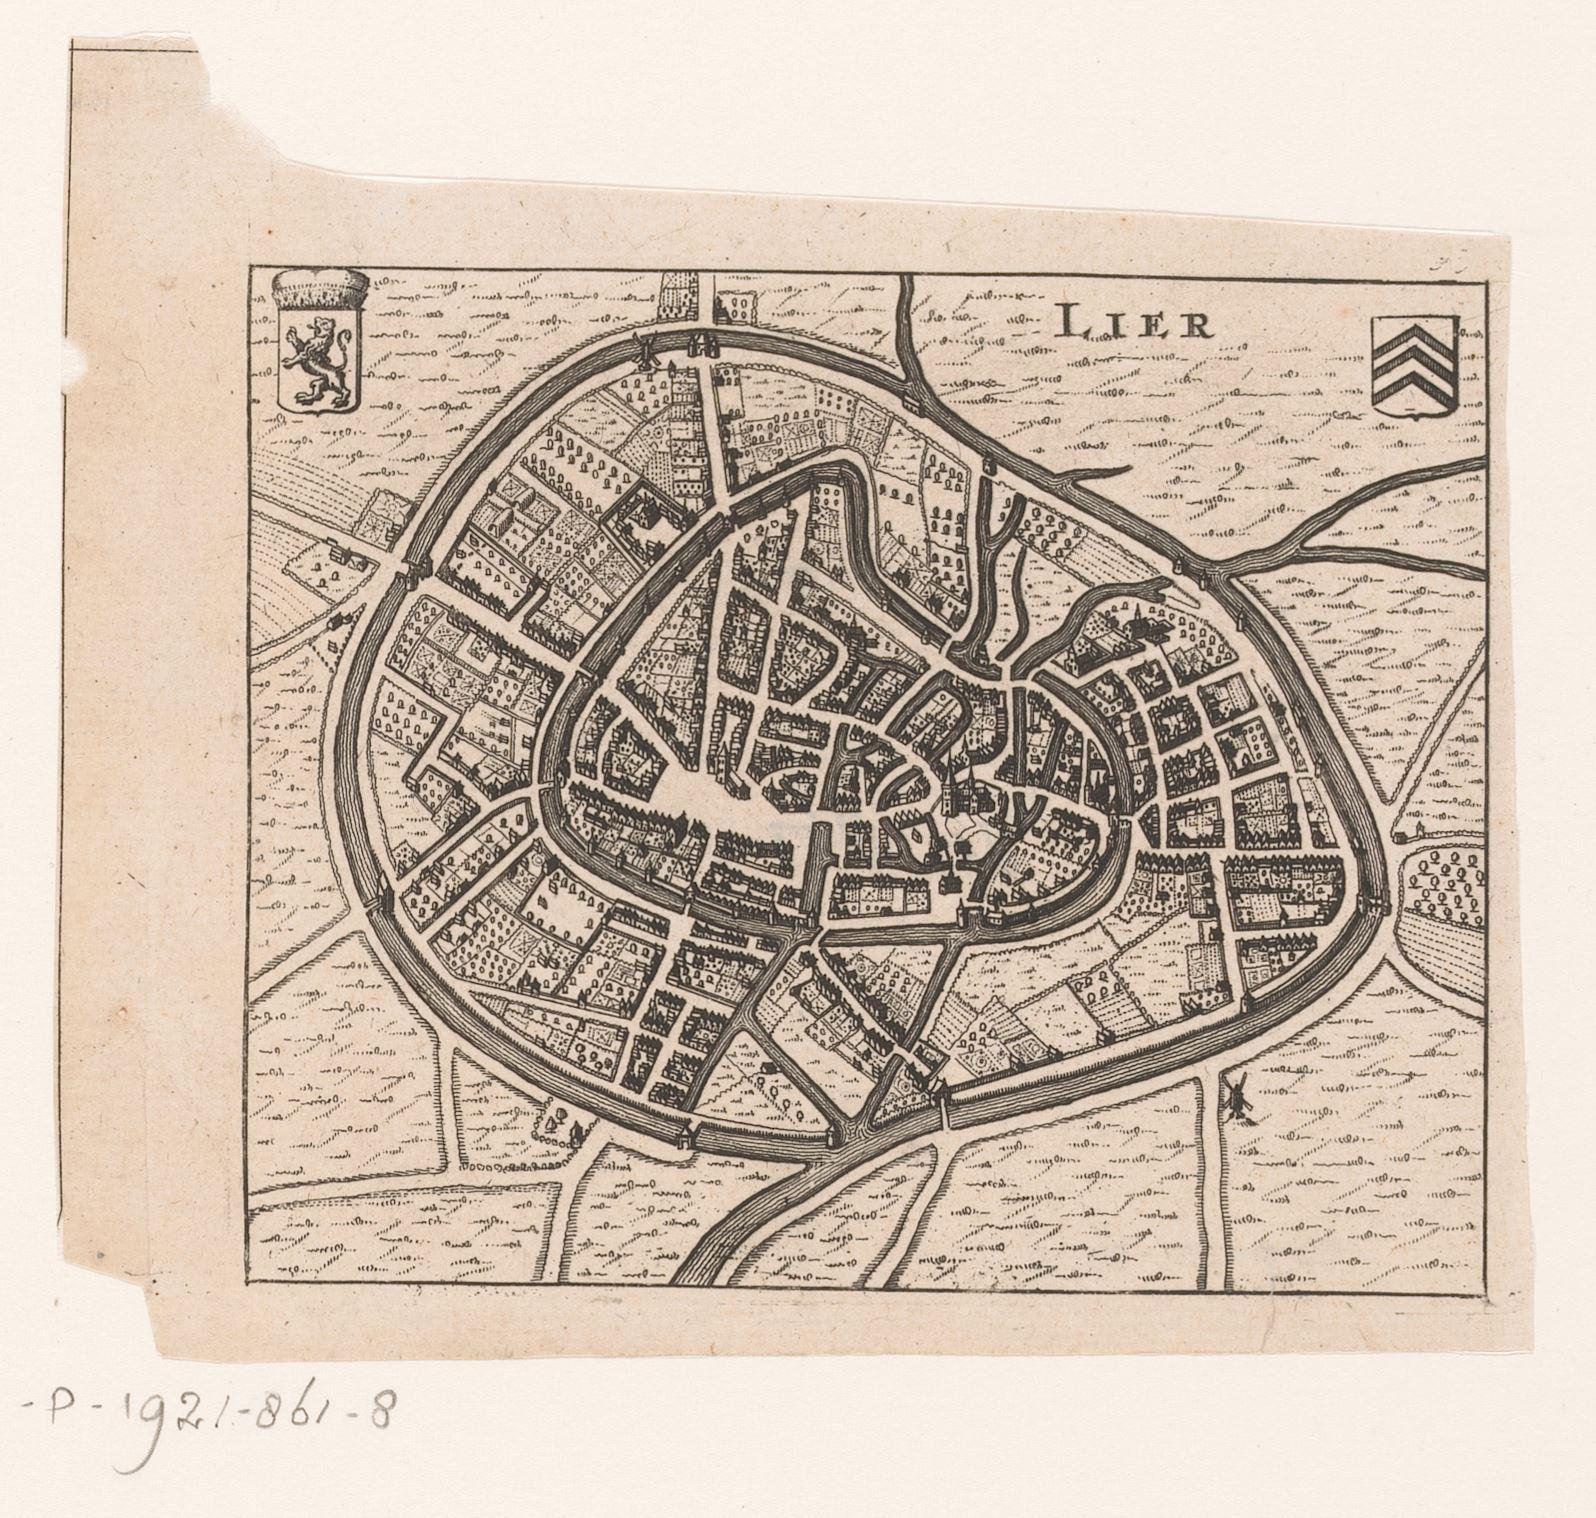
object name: book illustration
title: Lier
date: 1660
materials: paper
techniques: etching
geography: netherlands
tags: maps of cities, lierre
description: Prent uit: Guicciardini, Lodovico. Belgicae sive inferioris Germaniae Descriptio (...). Amsterdam: Jacob van Meurs, 1660. Deze prent komt ook voor in de Nederlandse editie van hetzelfde werk: Guicciardini, Lodovico. Beschryvingh der Neder-landen (...).Amsterdam: Jacob van Meurs, 1660 [en tevens in de herdruk van 1662].